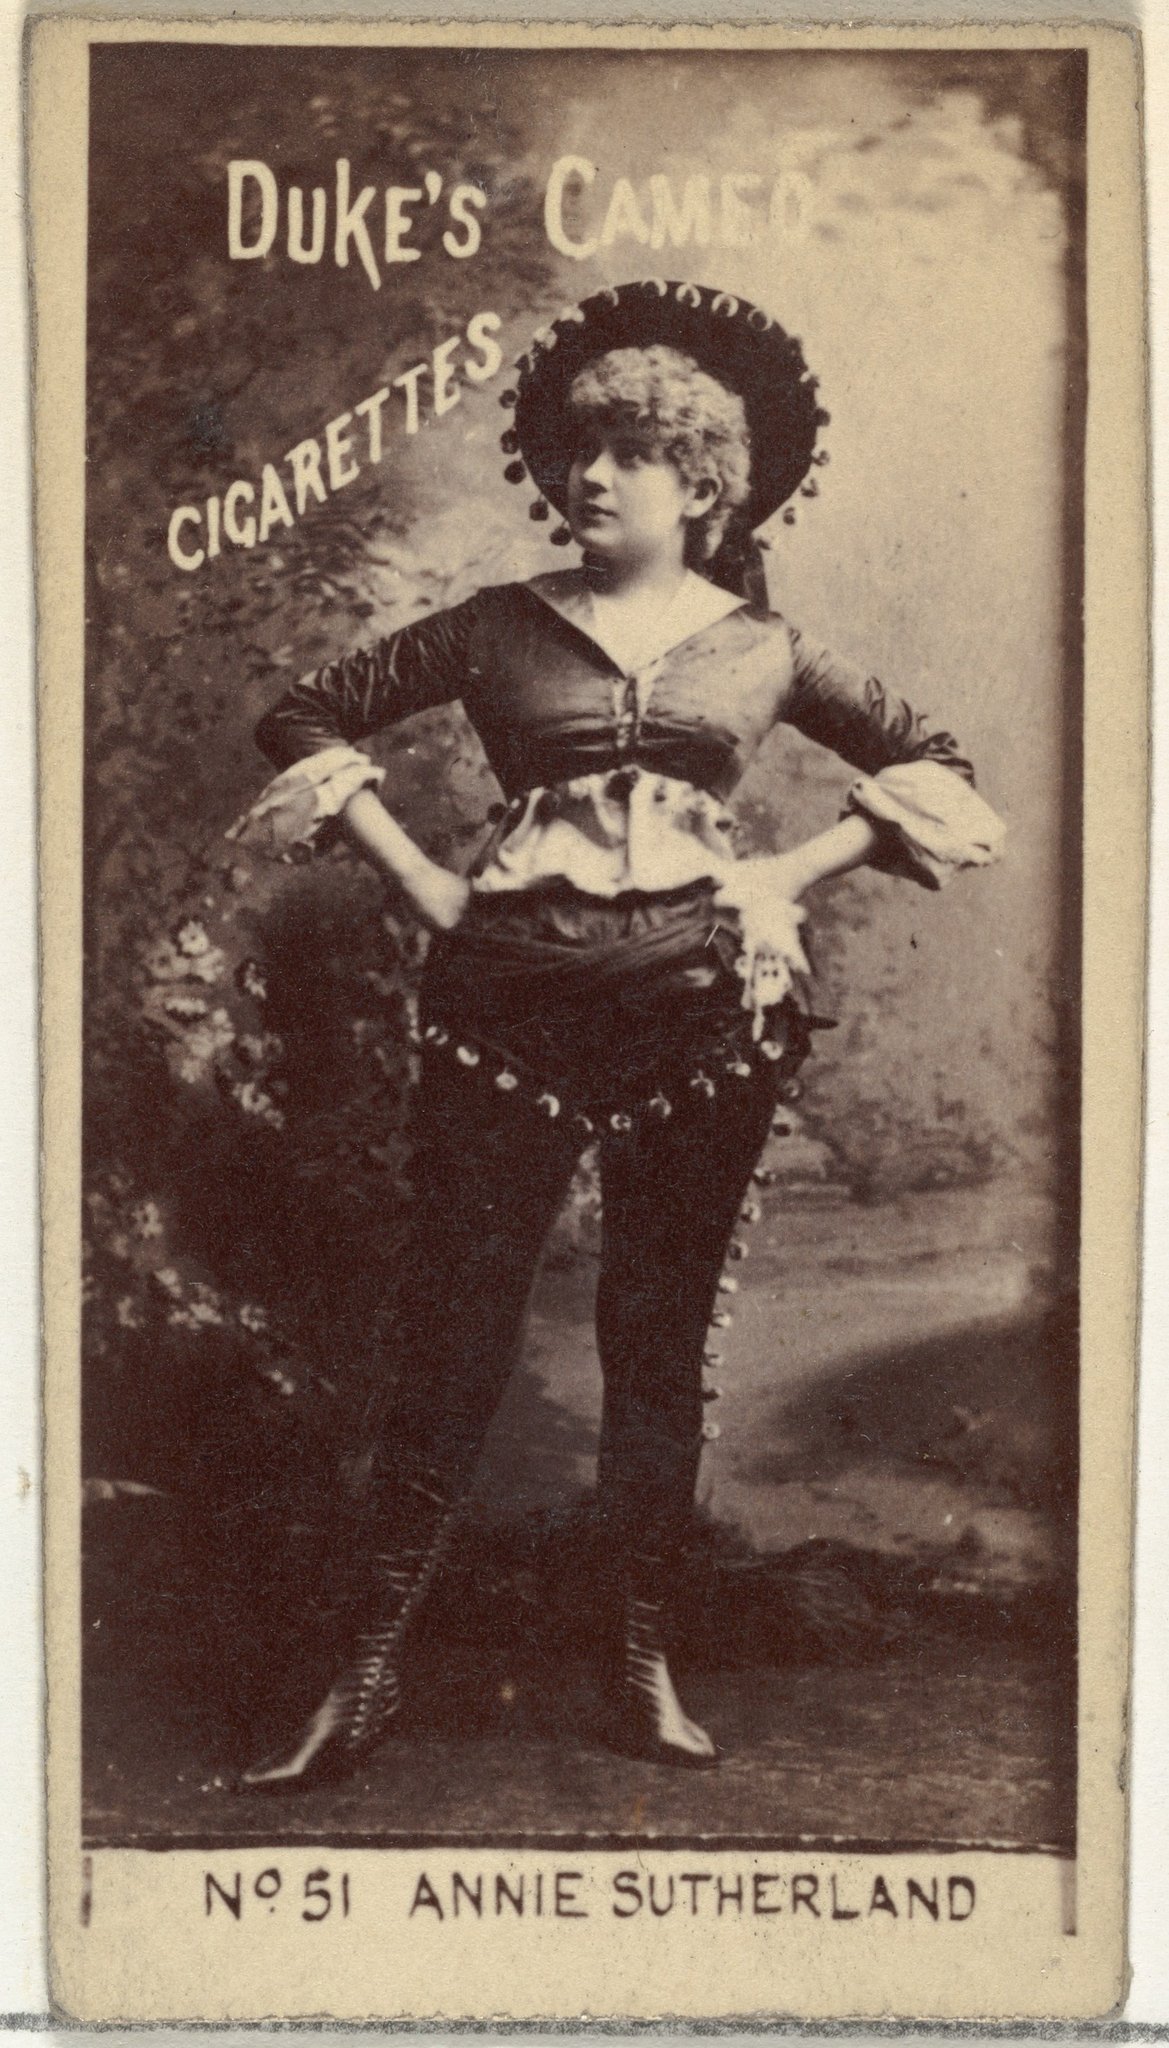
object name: photograph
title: Card Number 51, Annie Sutherland, from the Actors and Actresses series (N145-4) issued by Duke Sons & Co. to promote Cameo Cigarettes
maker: w. duke, sons & co.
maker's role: publisher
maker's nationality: american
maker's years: 1870-1920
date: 1880-1889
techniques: albumen silver print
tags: portraits,women,actresses